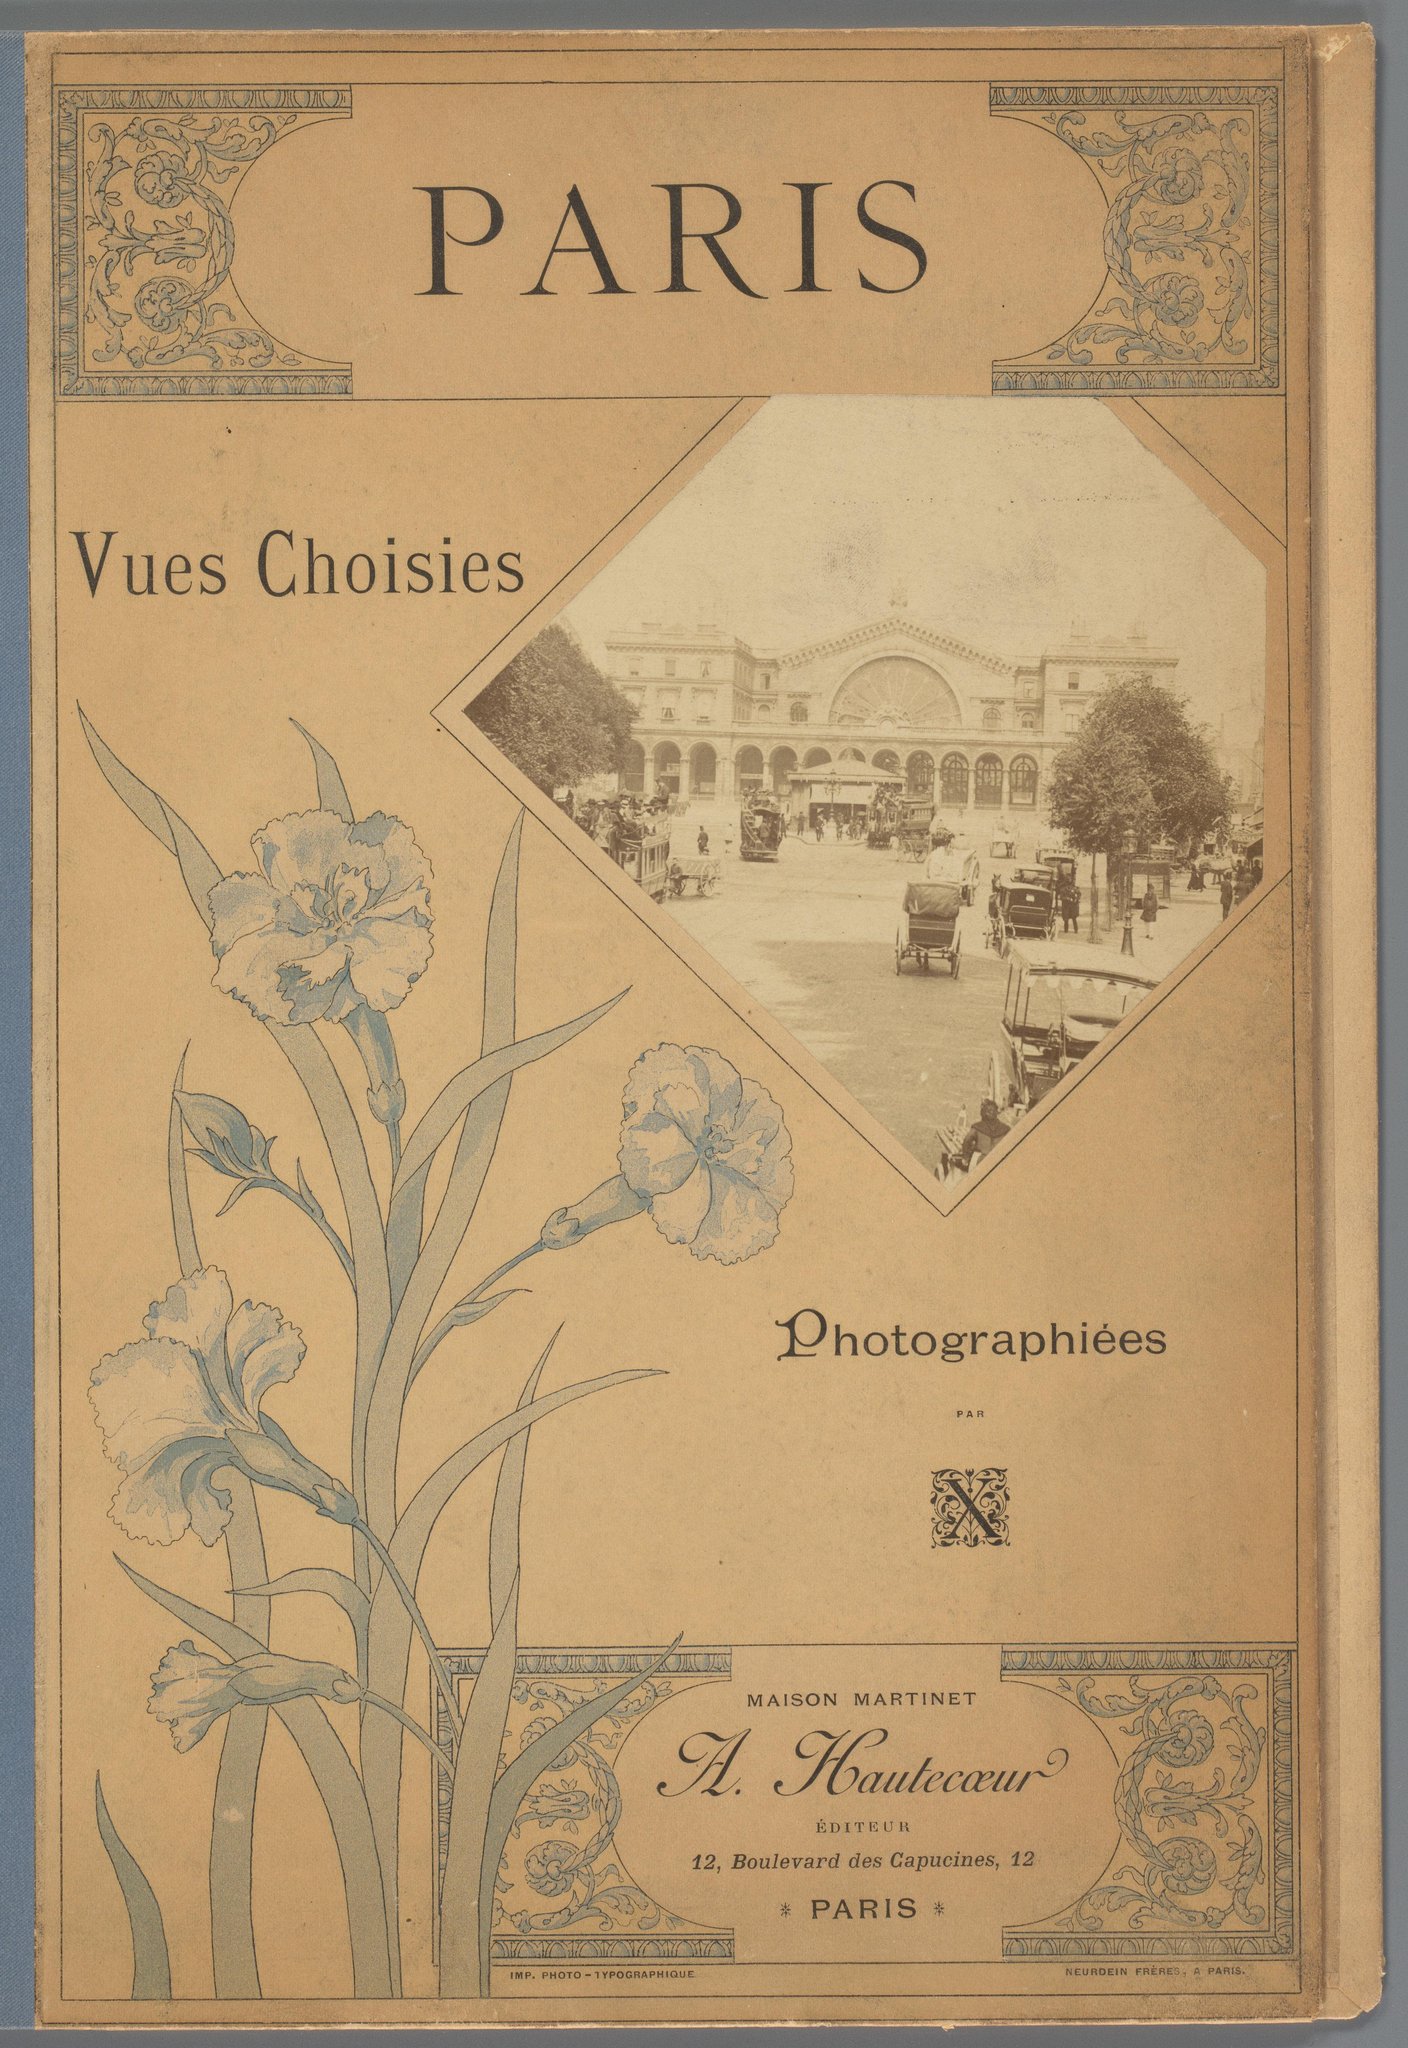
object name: wrapper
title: Paris. Vues Choisies. Photographiées par X.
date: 1860-1890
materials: cardboard, paper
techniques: albumen print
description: Deze omslag bevat twaalf foto's van Parijs.